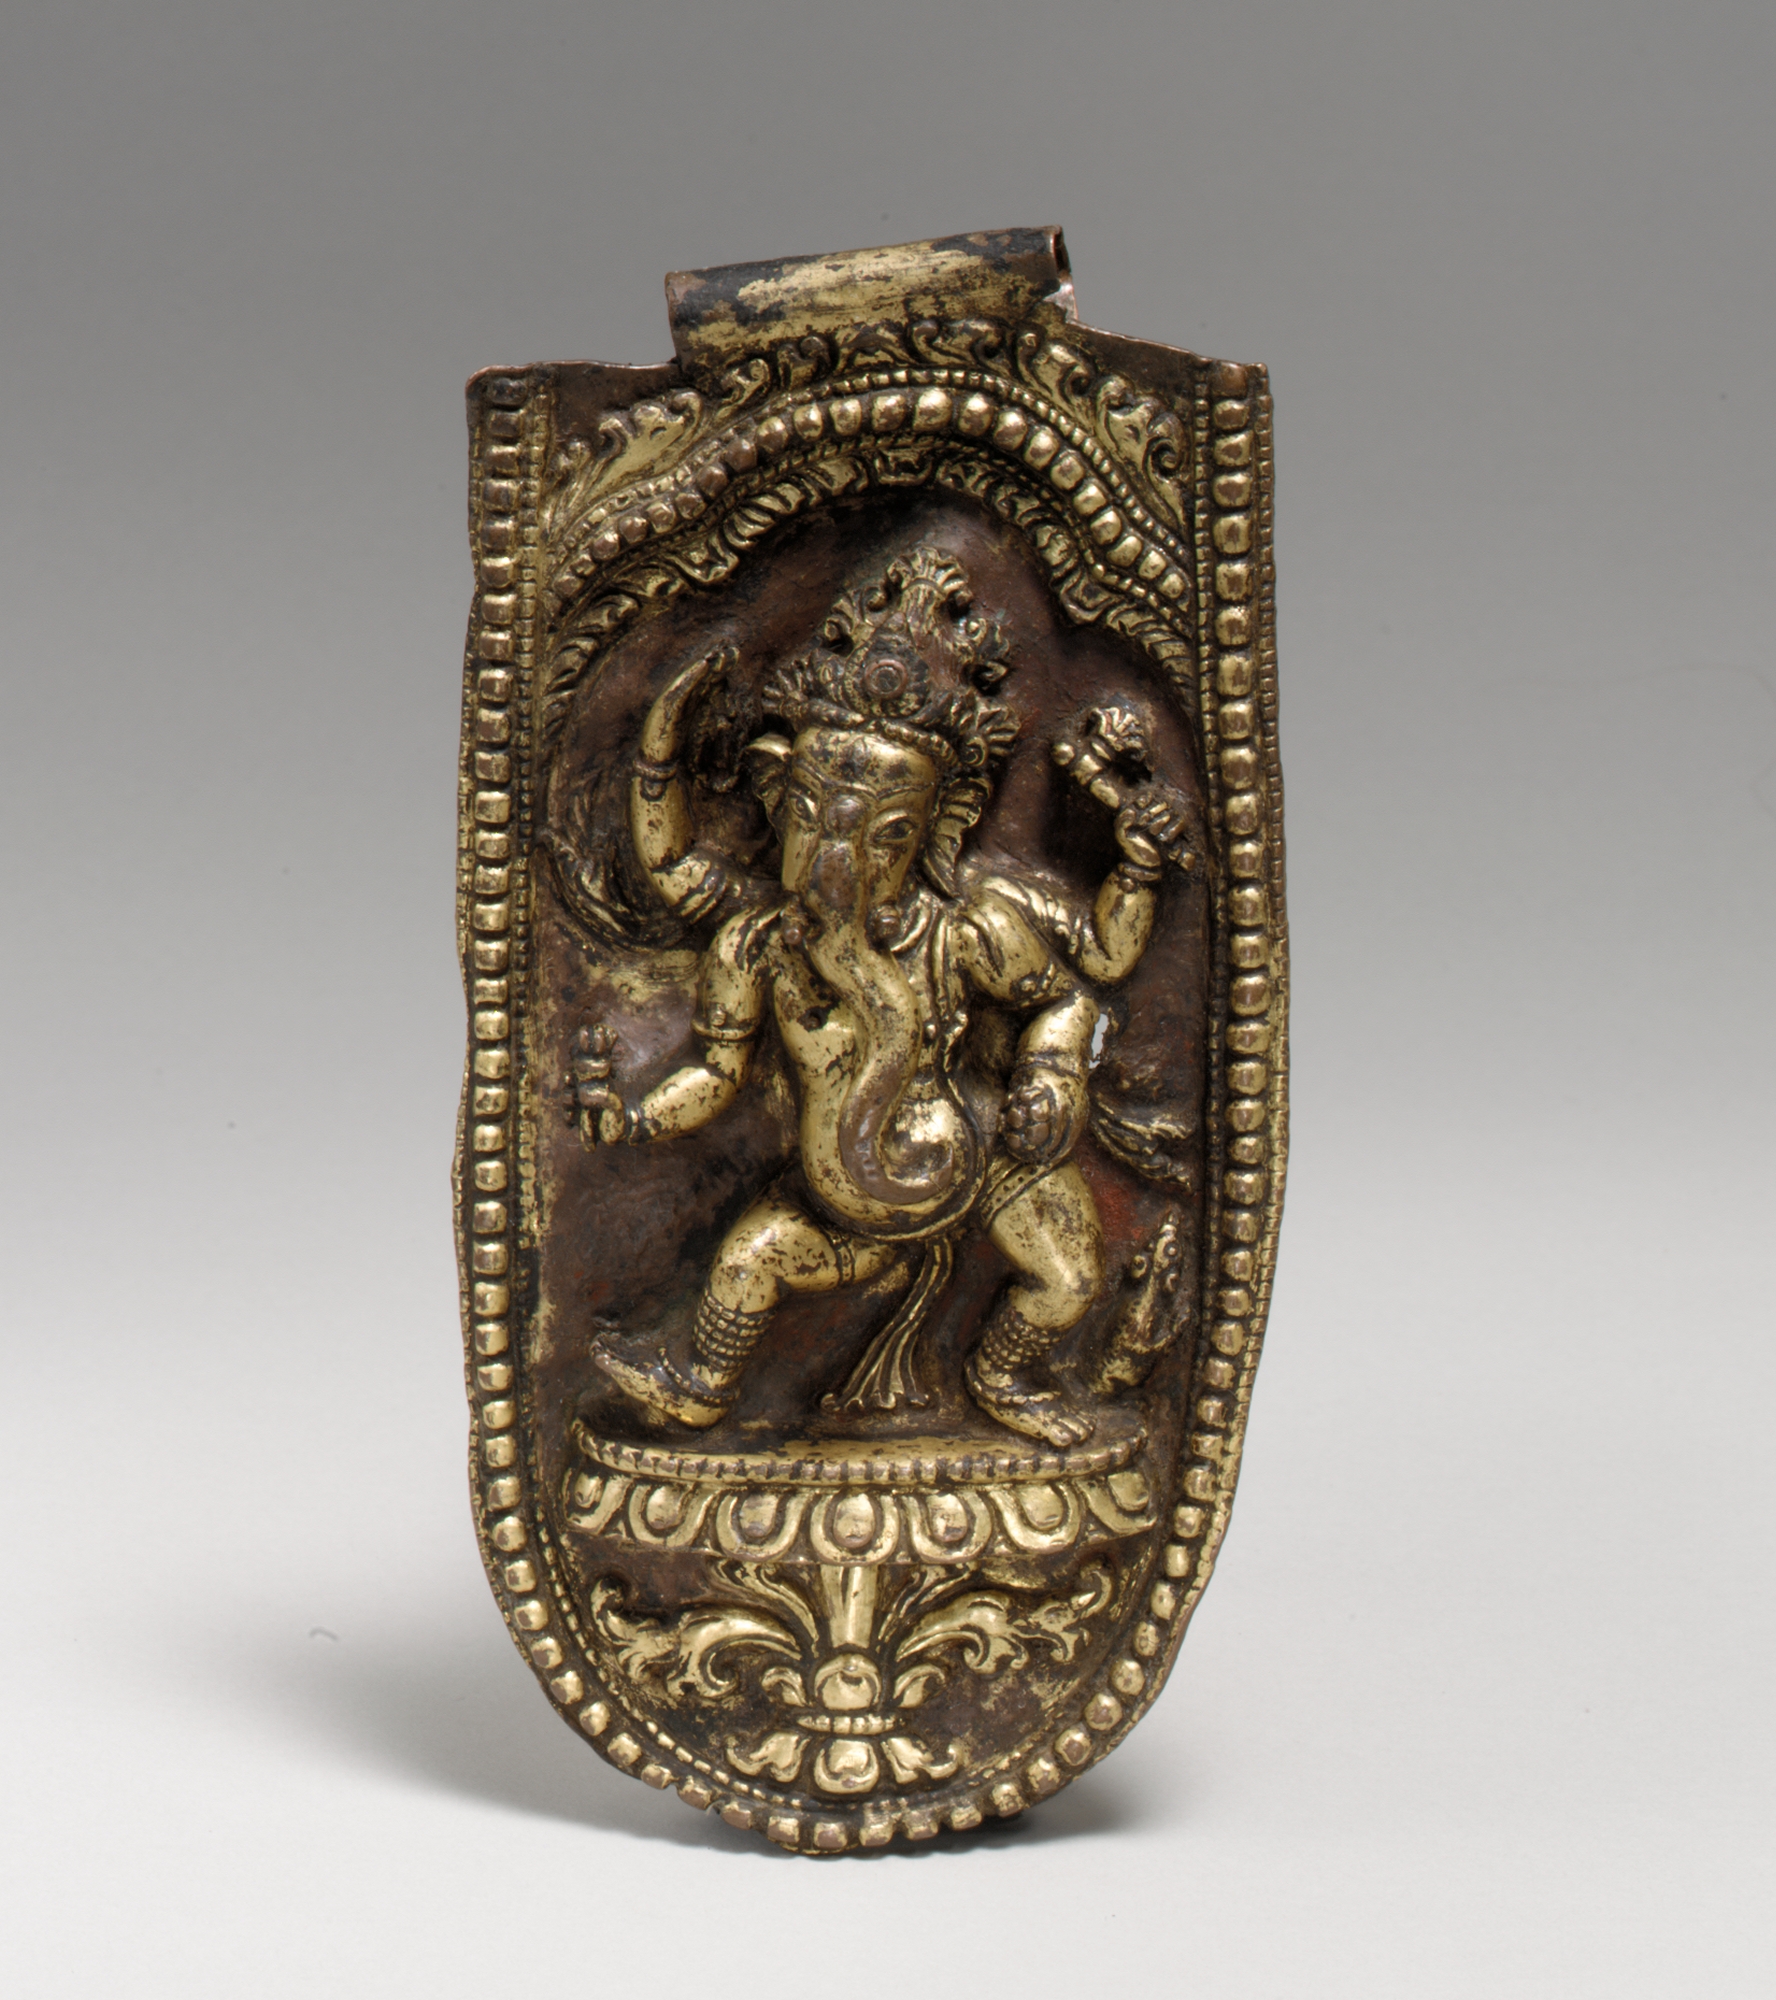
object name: plaque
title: Four-Armed Ganesha Dancing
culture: nepali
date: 1501-1700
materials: copper alloy, gilt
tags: dancing,elephants,ganesha